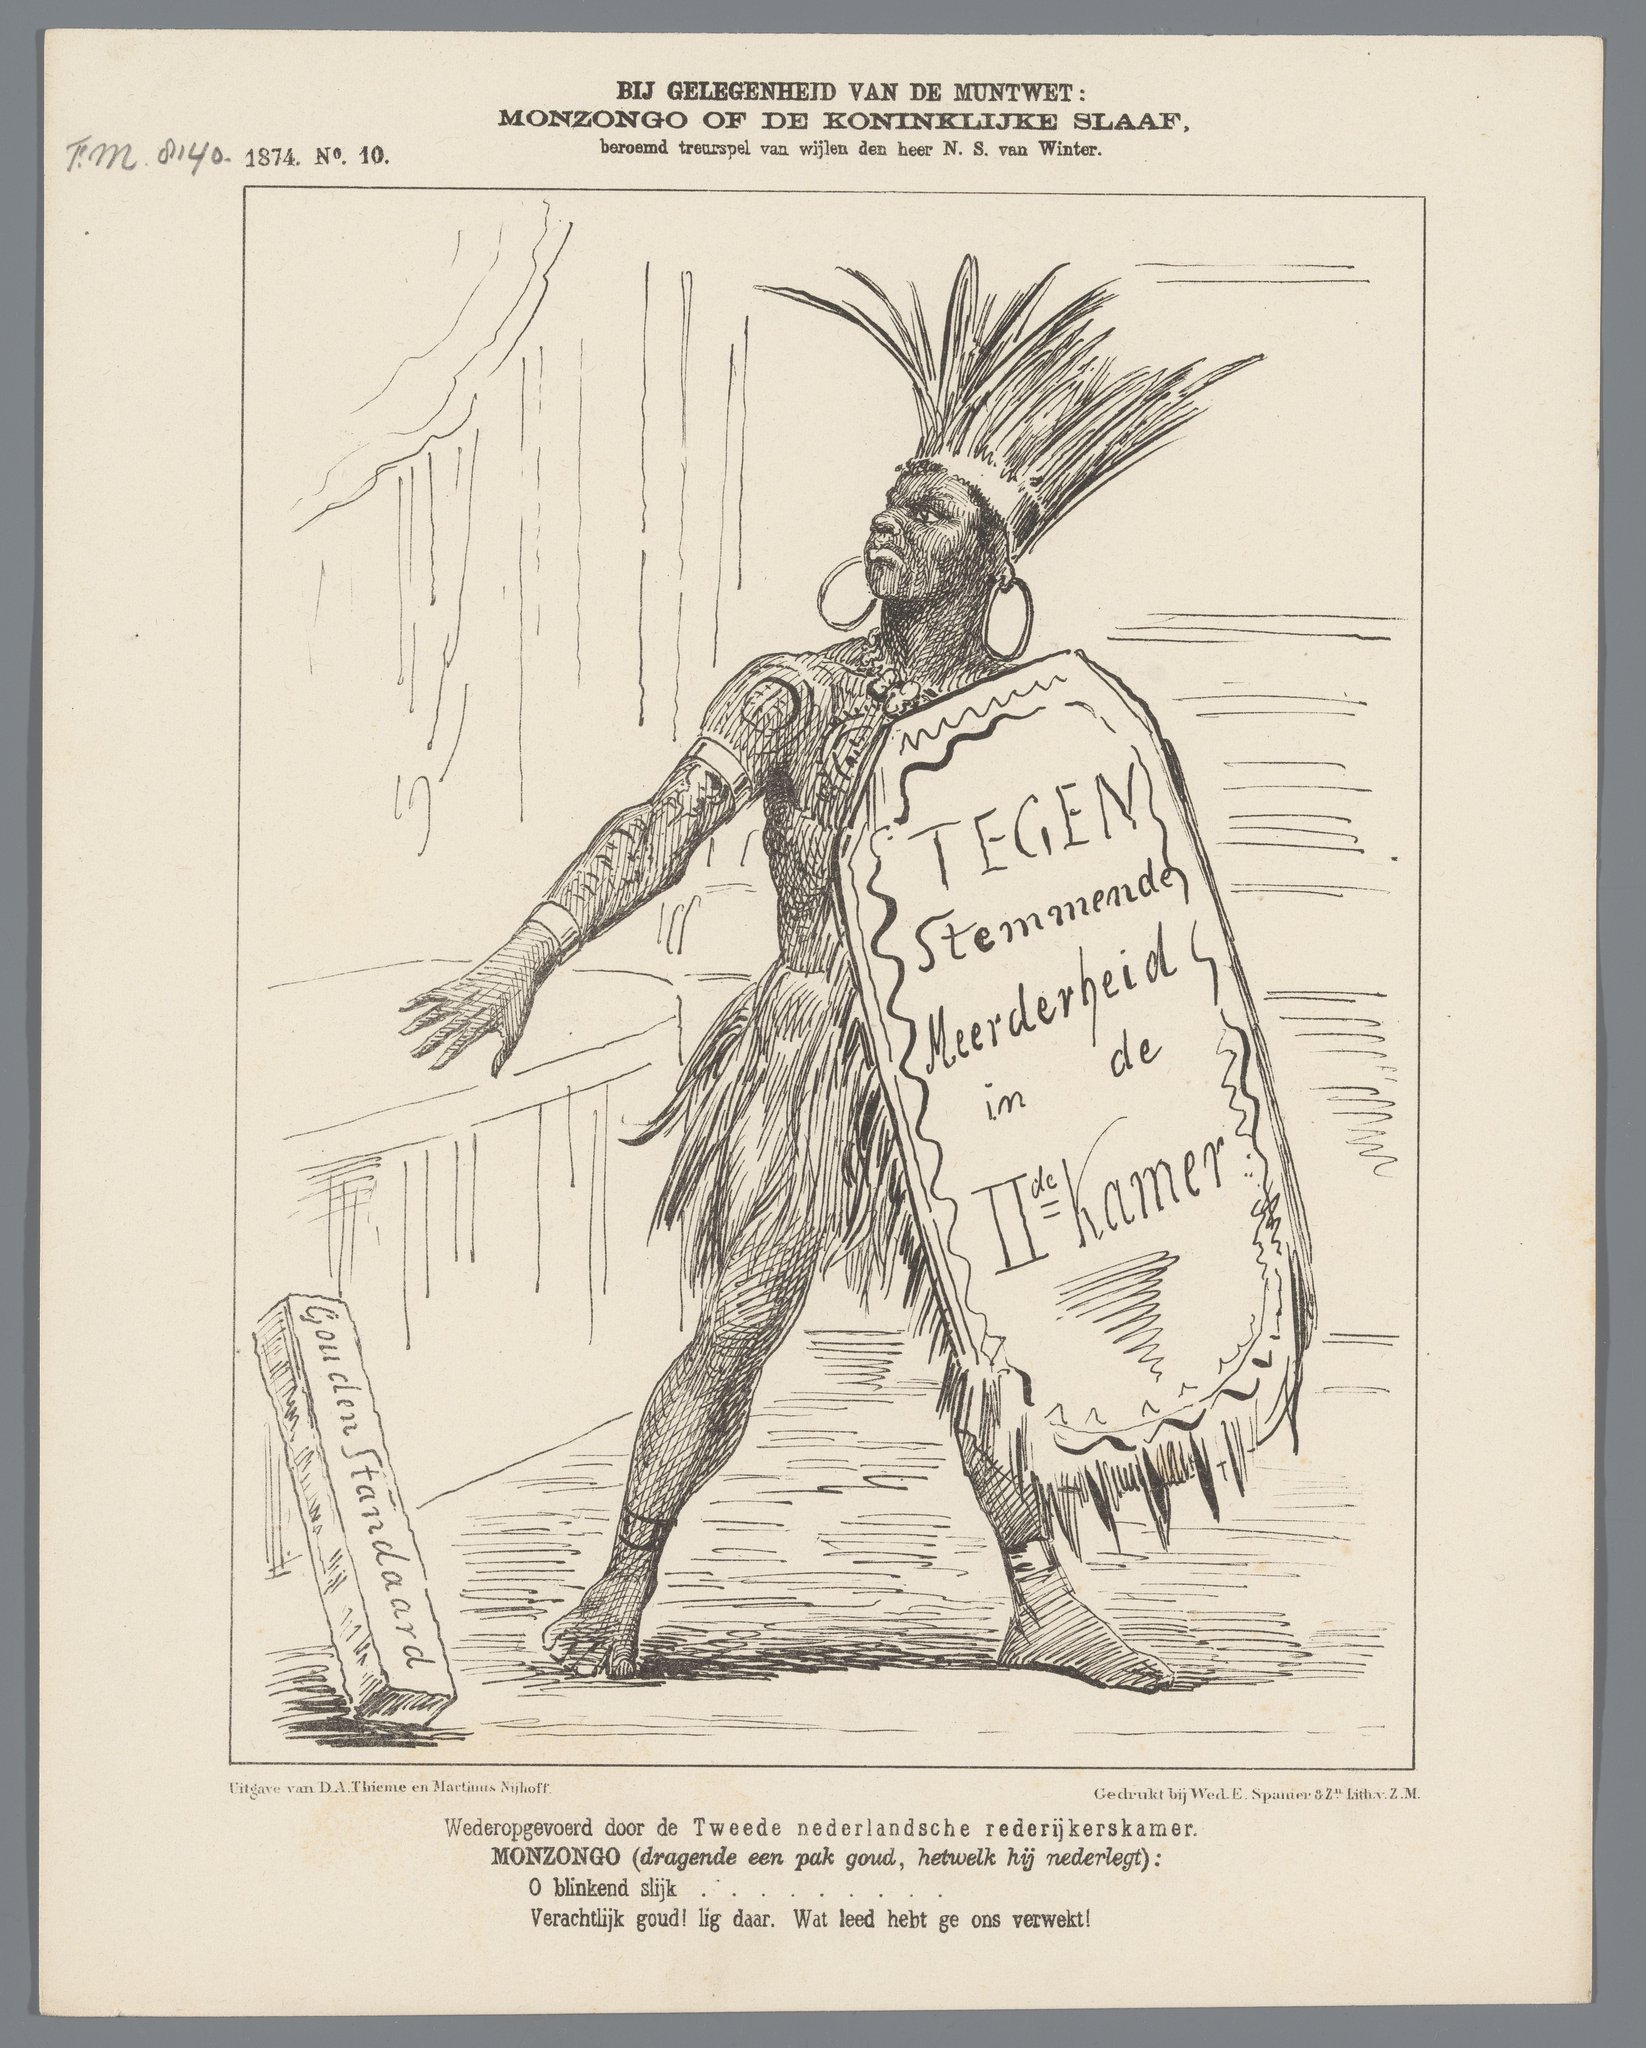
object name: cartoon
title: Bij gelegenheid van de muntwet: Monzongo of de Koninklijke Slaaf, beroemd treurspel van wijlen den heer N.S. van Winter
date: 1874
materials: paper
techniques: lithograph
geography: arnhem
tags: africans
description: Een Afrikaan met een schild een gouden staaf wegwerpende. Spotprent op de verwerping van de muntwet, 1874. Plaat verschenen bij het weekblad De Nederlandsche Spectator, nr. 10, 1874.